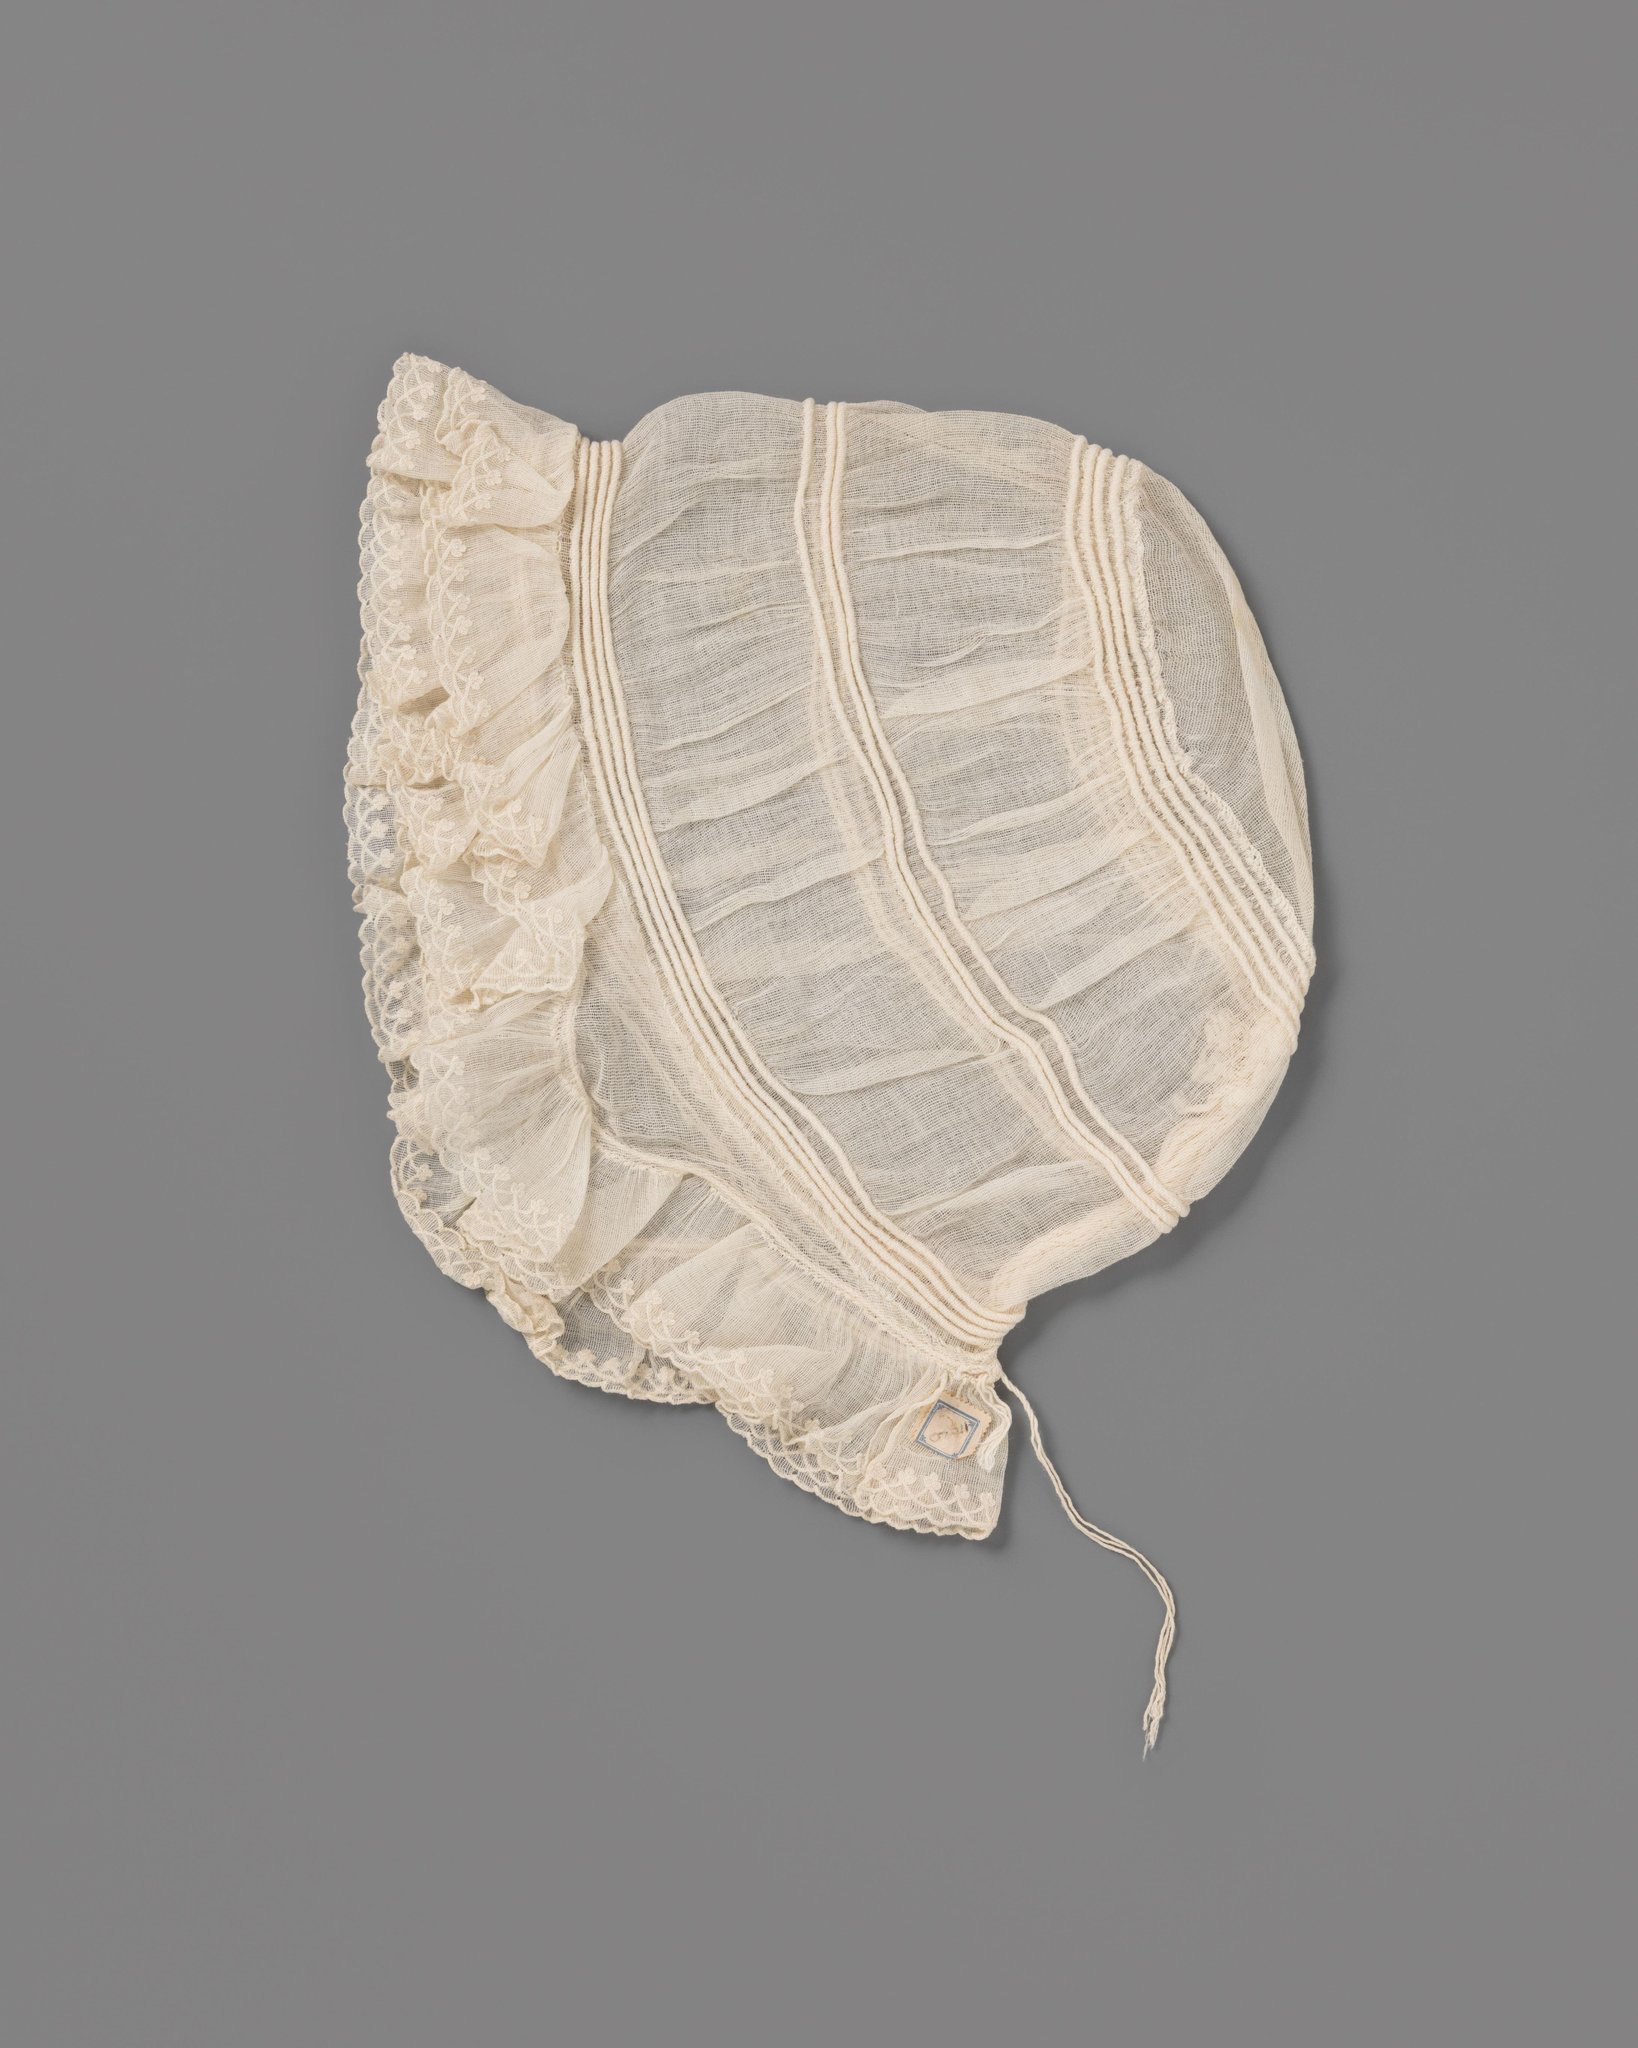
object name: cap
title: Muts van buckram met drie opgeregen, met koord gevulde streepversieringen en geborduurde stroken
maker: Anonymous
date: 1850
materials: textile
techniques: embroidered, stitch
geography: western europe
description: Muts van buckram met drie opgeregen, met koord gevulde streepversieringen. De ronde mutsenbodem is afgezet met een geirmpelde strook versierd met een kettingsteek; op het voorhoofd een verdubbelde strook.